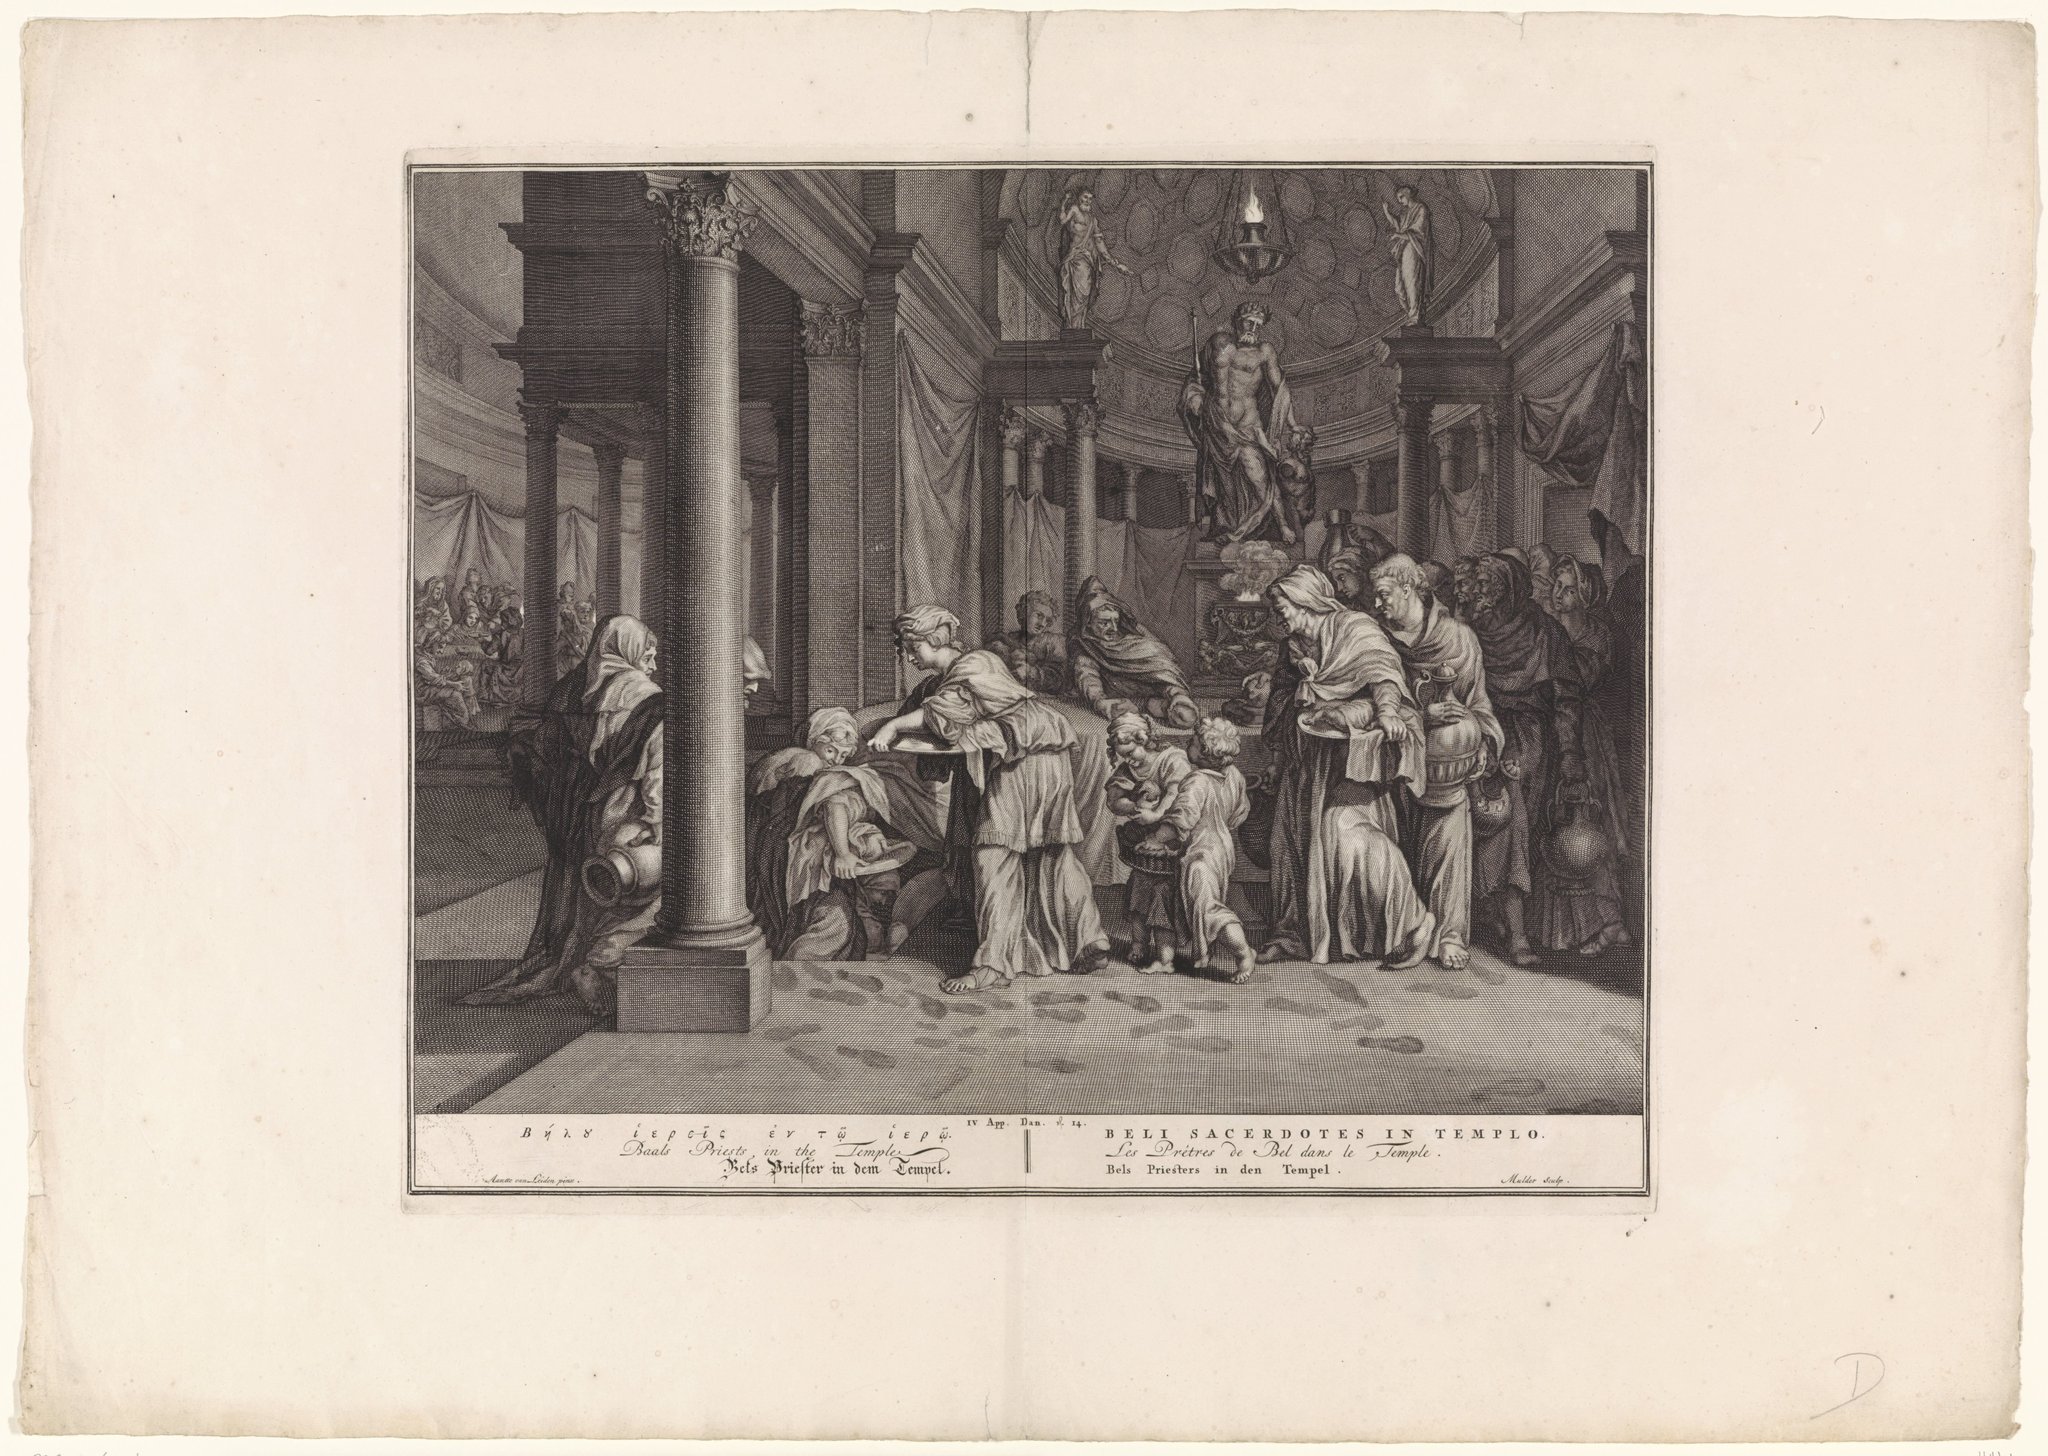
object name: print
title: Bels priesters in de tempel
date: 1720-1728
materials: paper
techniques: engraving, etching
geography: amsterdam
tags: the priests of bel, with their wives and children, enter the temple through a hidden corridor and feast on the food during the night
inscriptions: collector's mark: Lugt 2228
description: De priesters van Bel eten het aan de god Bel geofferde voedsel. Ze komen en gaan door een geheime gang onder de tafel. Terwijl ze heimelijk het voedsel nemen, blijven hun voetstappen achter in de door Daniël op de grond gestrooide as. Onderaan in de marge een verwijzing naar de Bijbeltekst en de titel in het Grieks, Engels, Latijn, Duits, Frans en Nederlands.